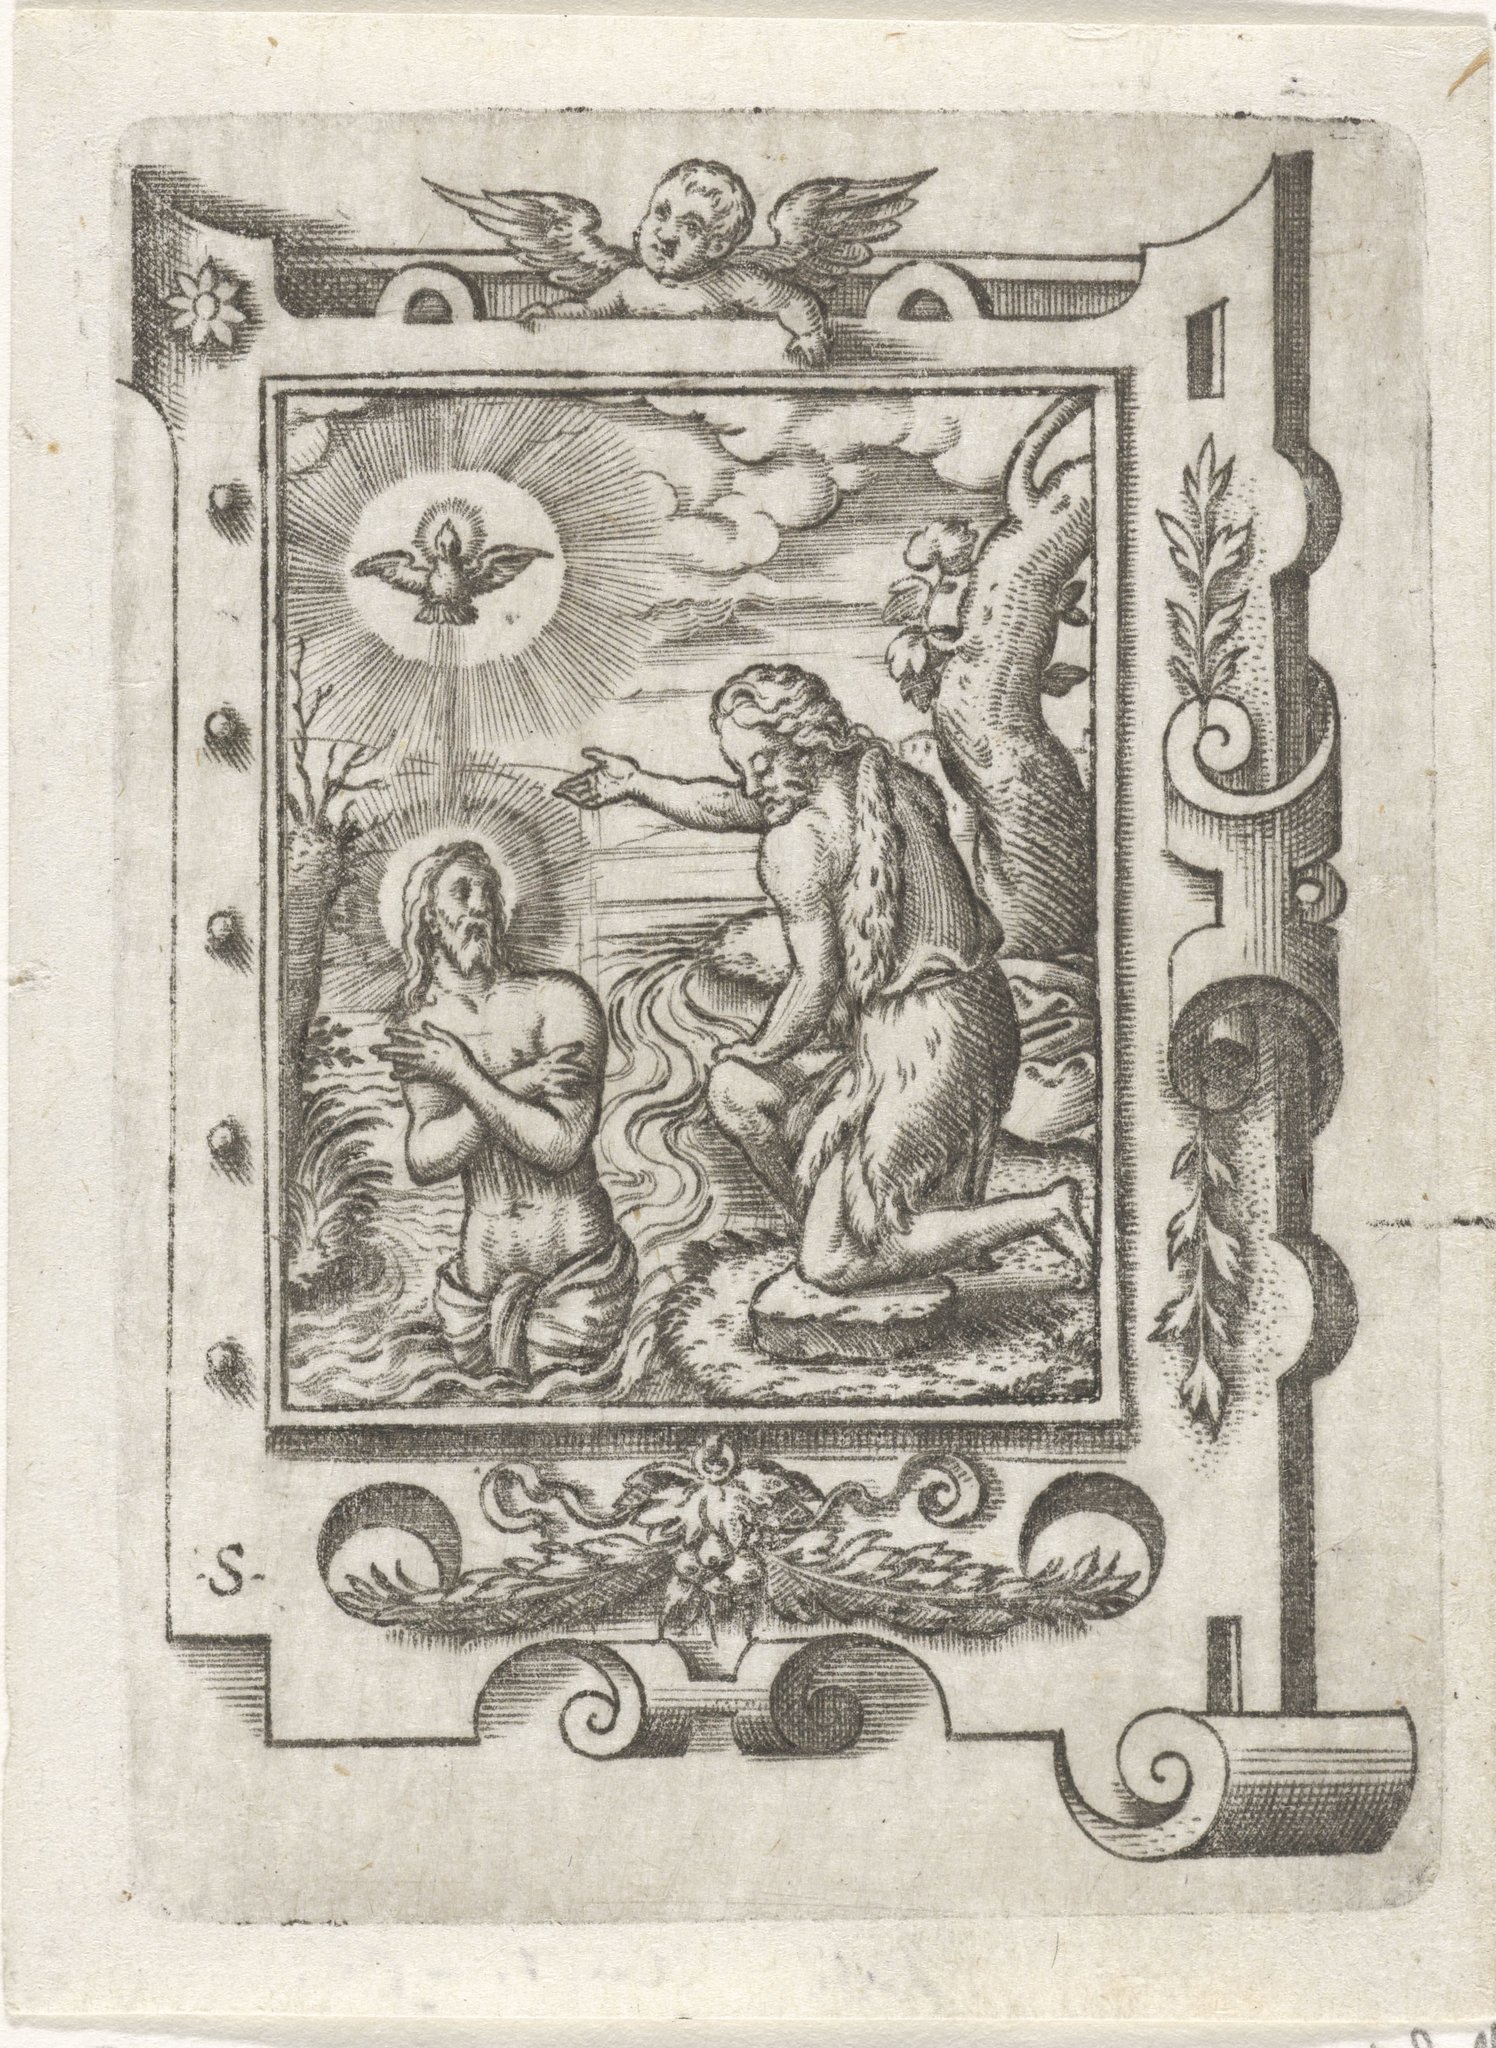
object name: print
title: De Doop van Christus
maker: virgilius solis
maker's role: draughtsman, print maker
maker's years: 1514-1562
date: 1524-1562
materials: paper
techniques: engraving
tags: baptism of christ in the river jordan: john the baptist pouring out water on christ's head: the holy ghost descends